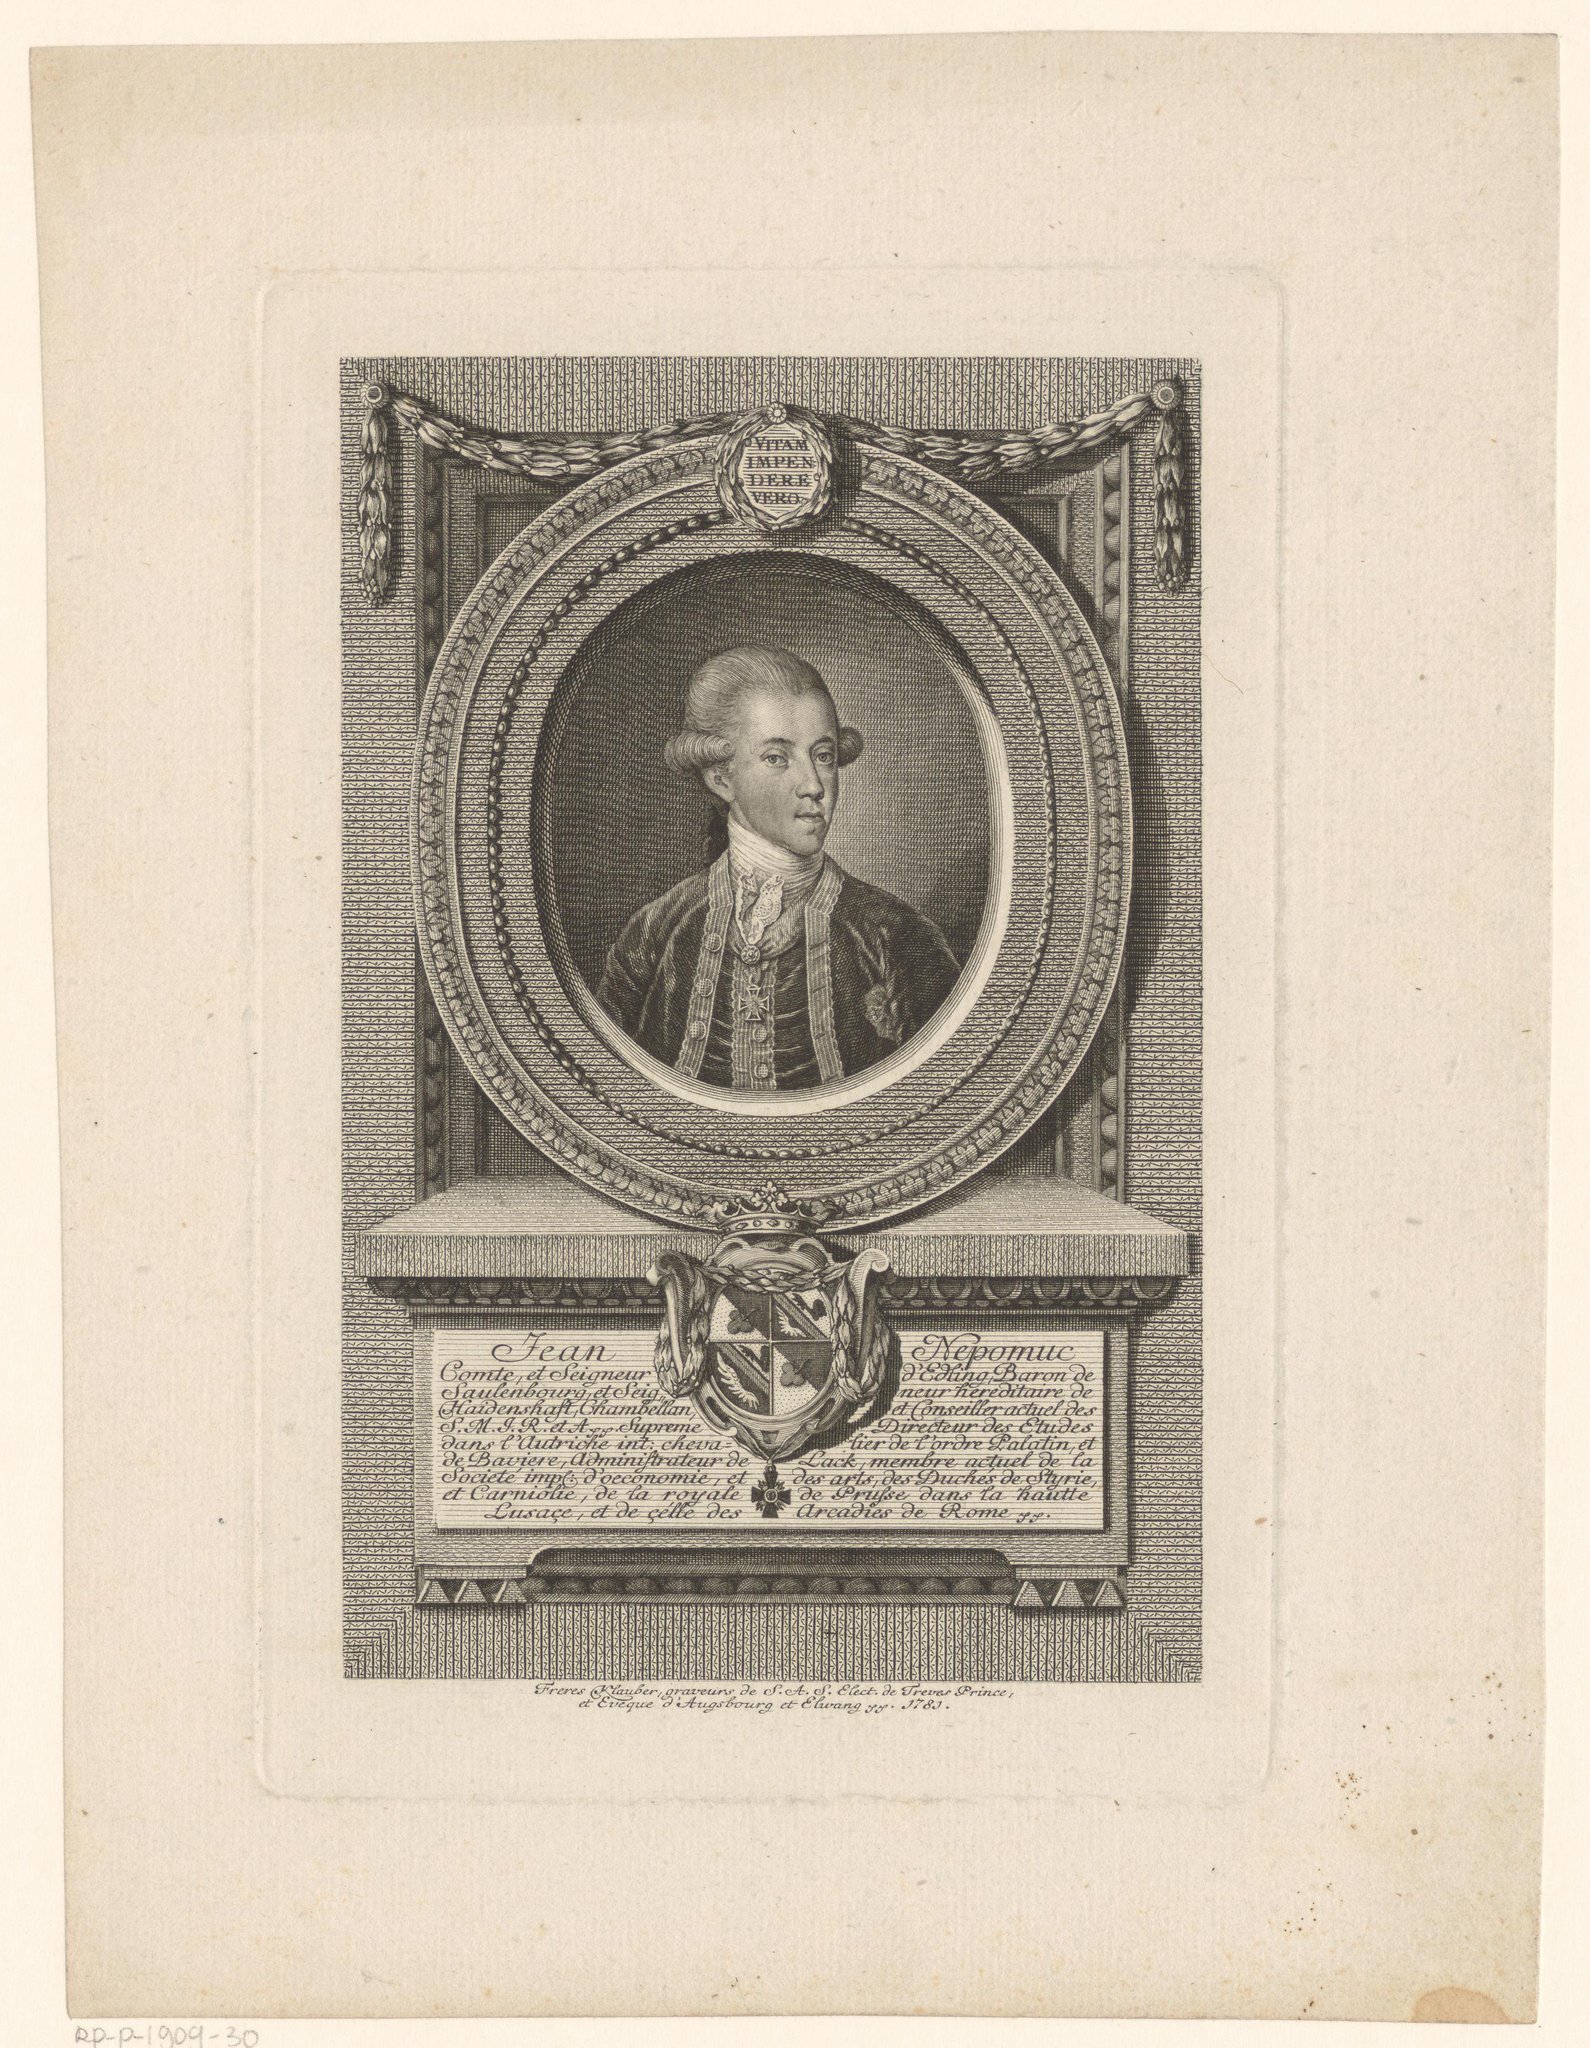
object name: print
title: Portret van Janez Nepomuk Jakob Edling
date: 1781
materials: paper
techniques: engraving, etching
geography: augsburg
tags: commander-in-chief, general, marshal, historical persons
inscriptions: collector's mark: Lugt 2228